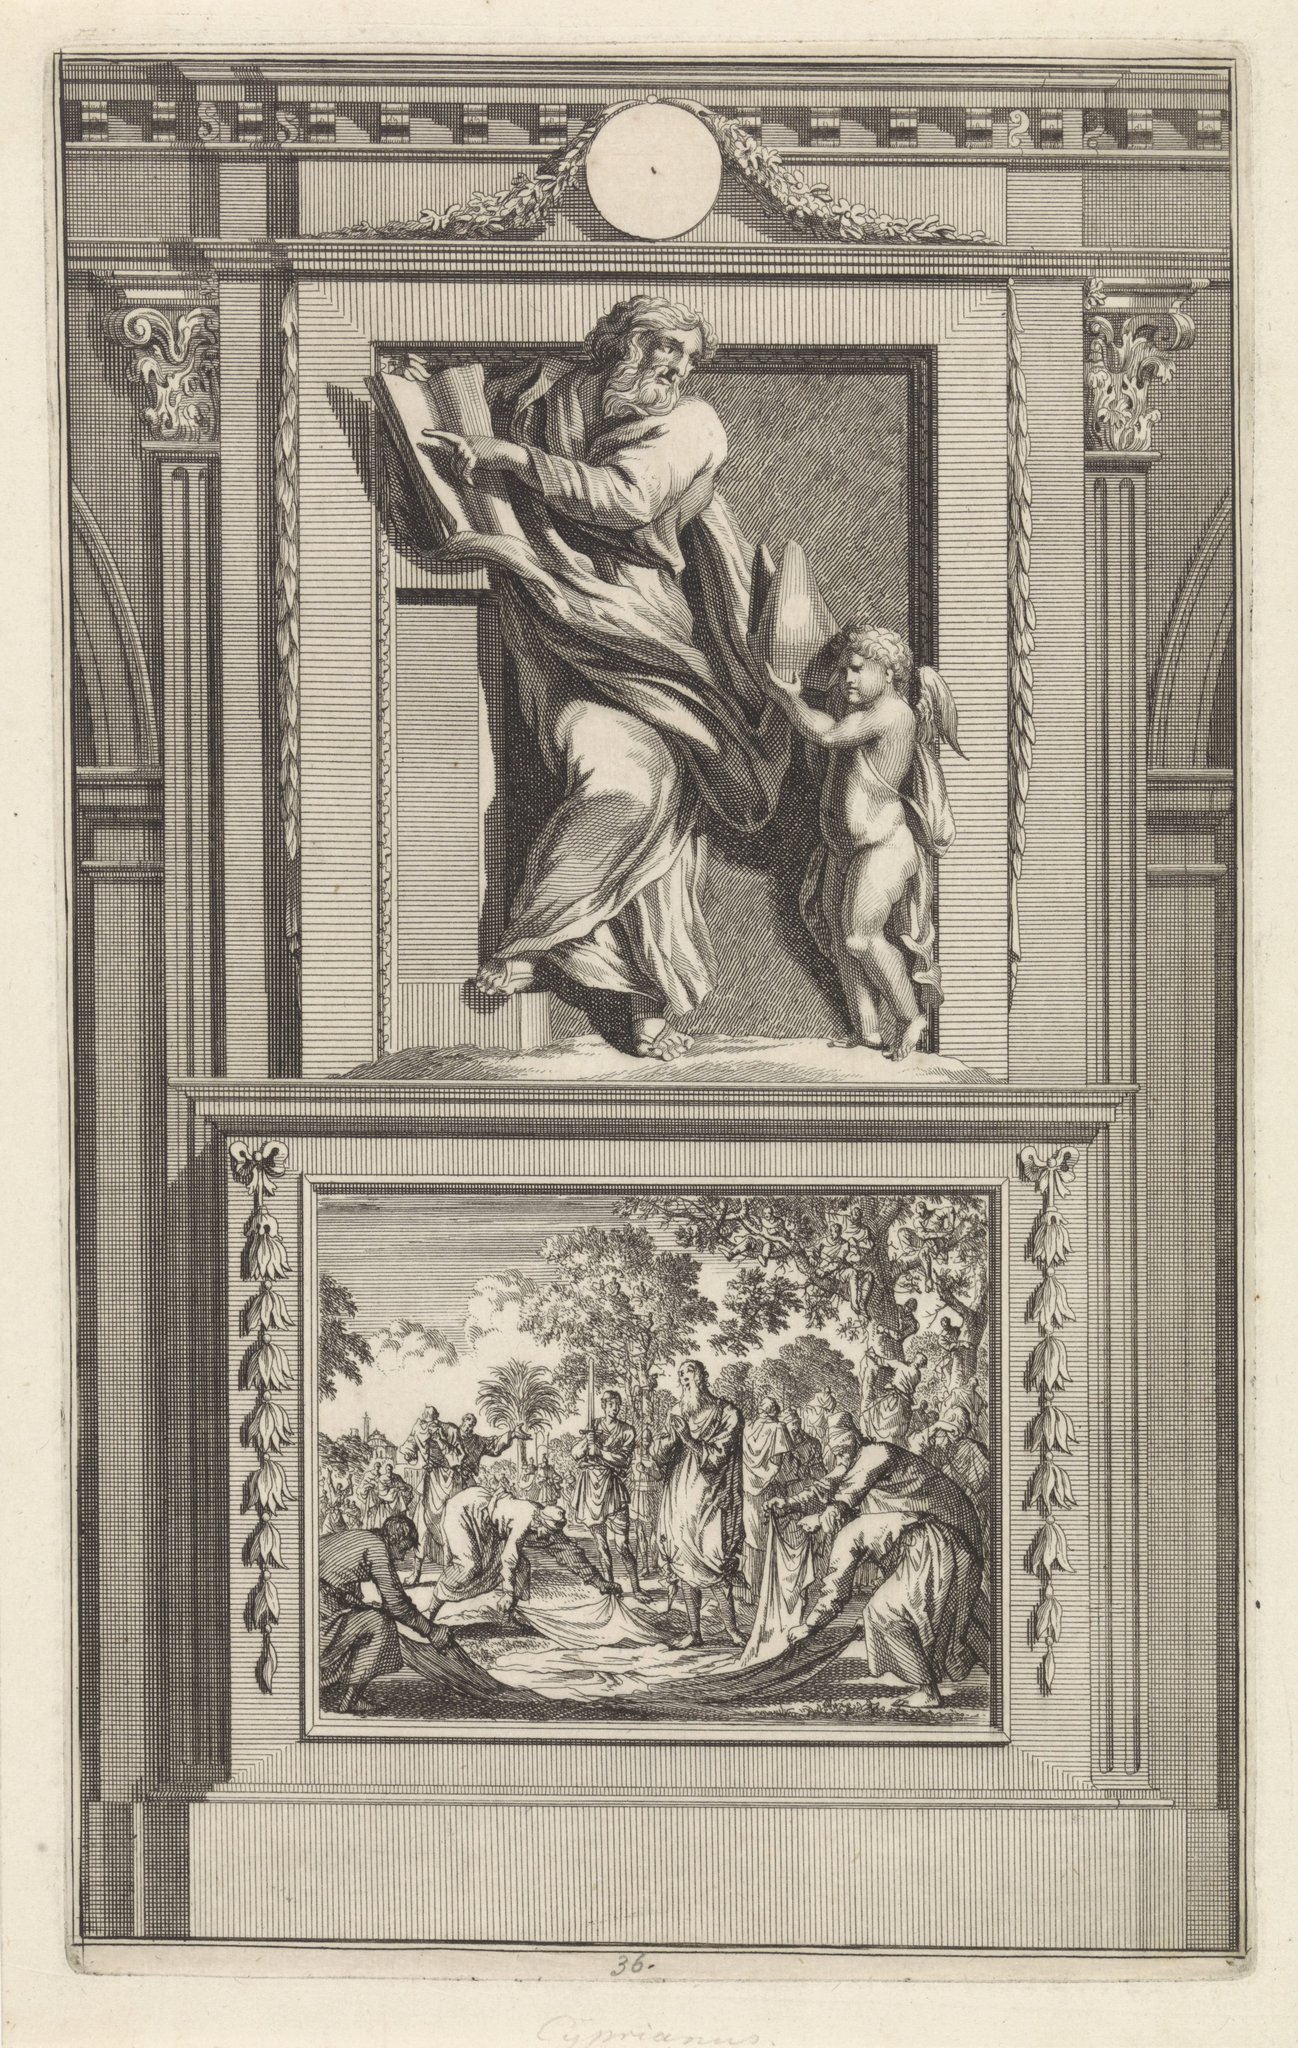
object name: print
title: H. Cyprianus van Carthago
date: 1698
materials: paper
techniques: engraving, etching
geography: amsterdam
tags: male saints (with name) - martyrdom, suffering, misfortune, death of male saint, male saints (with name), violent death by beheading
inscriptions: number: ‘36’, collector's mark: Lugt 2228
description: De heilige Cyprianus van Carthago wijst een engel met een mijter in de handen op een passage in een boek. Cyprianus staat op een sokkel waar op de voorzijde zijn onthoofding in beeld is gebracht.